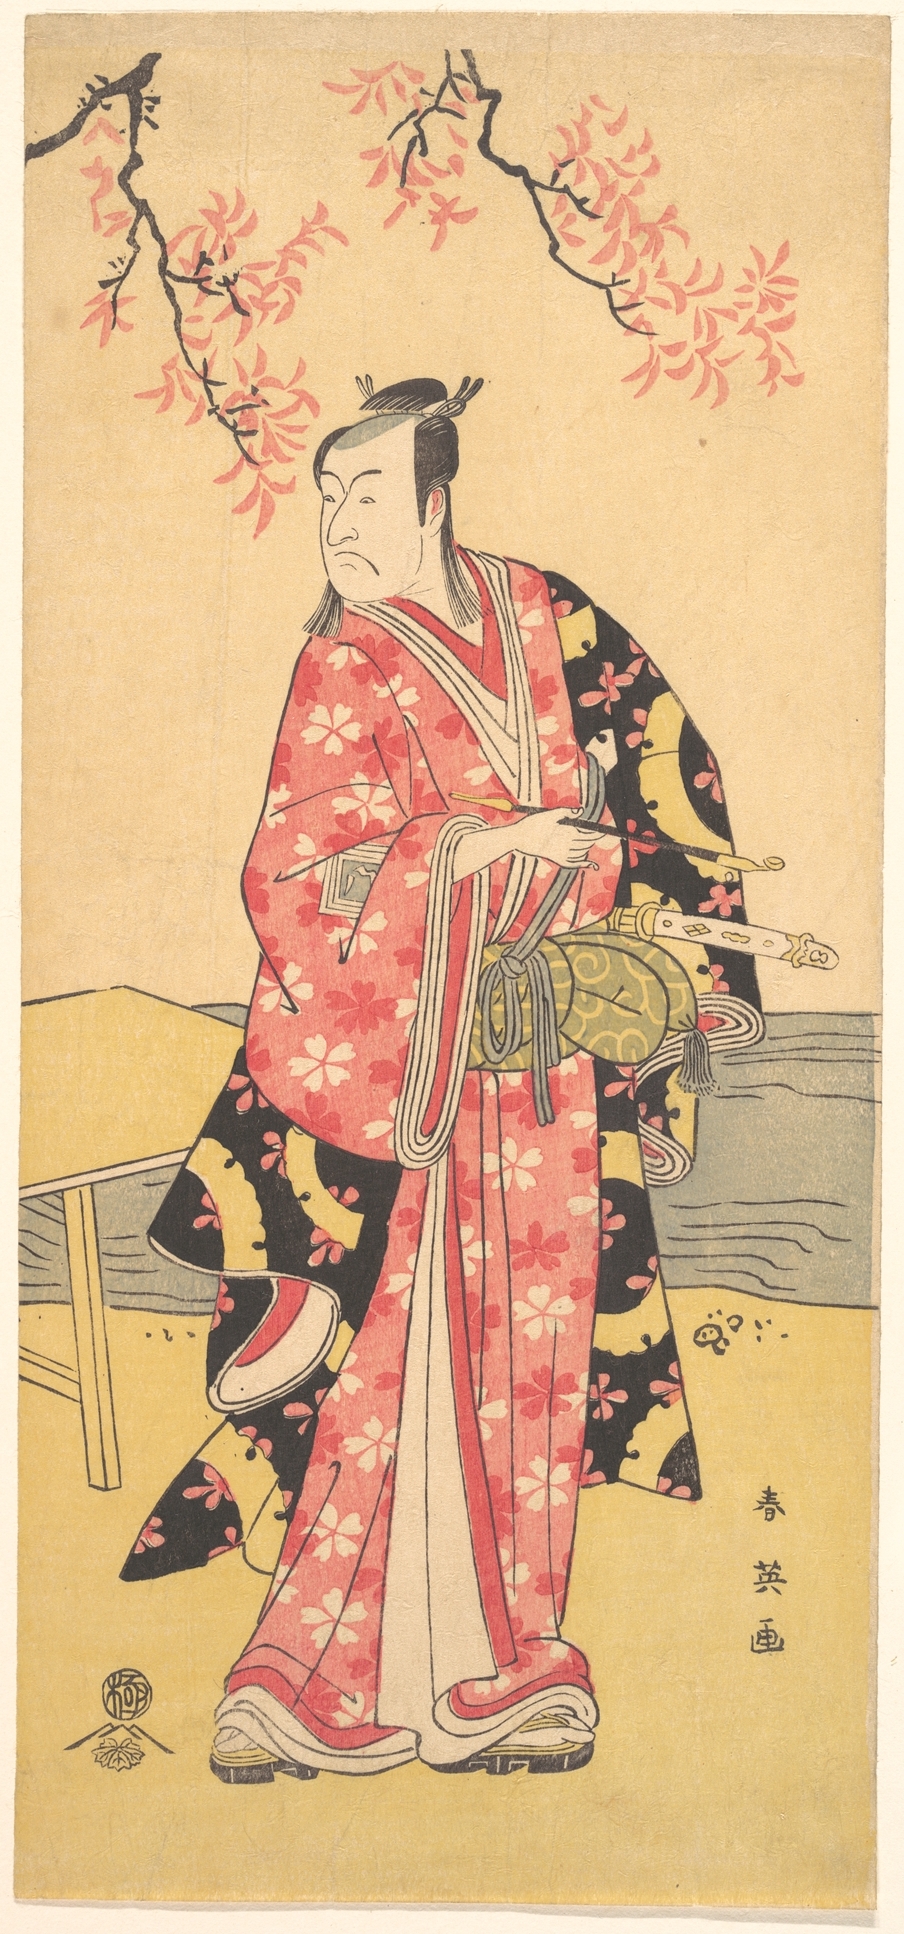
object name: print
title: The Actor Ichikawa Monosuke II as Chivalrous Commoner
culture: japanese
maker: katsukawa shun'ei 勝川春英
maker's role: artist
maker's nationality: japanese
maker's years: 1762-1819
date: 1790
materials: ink, paper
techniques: woodblock print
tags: trees,actors